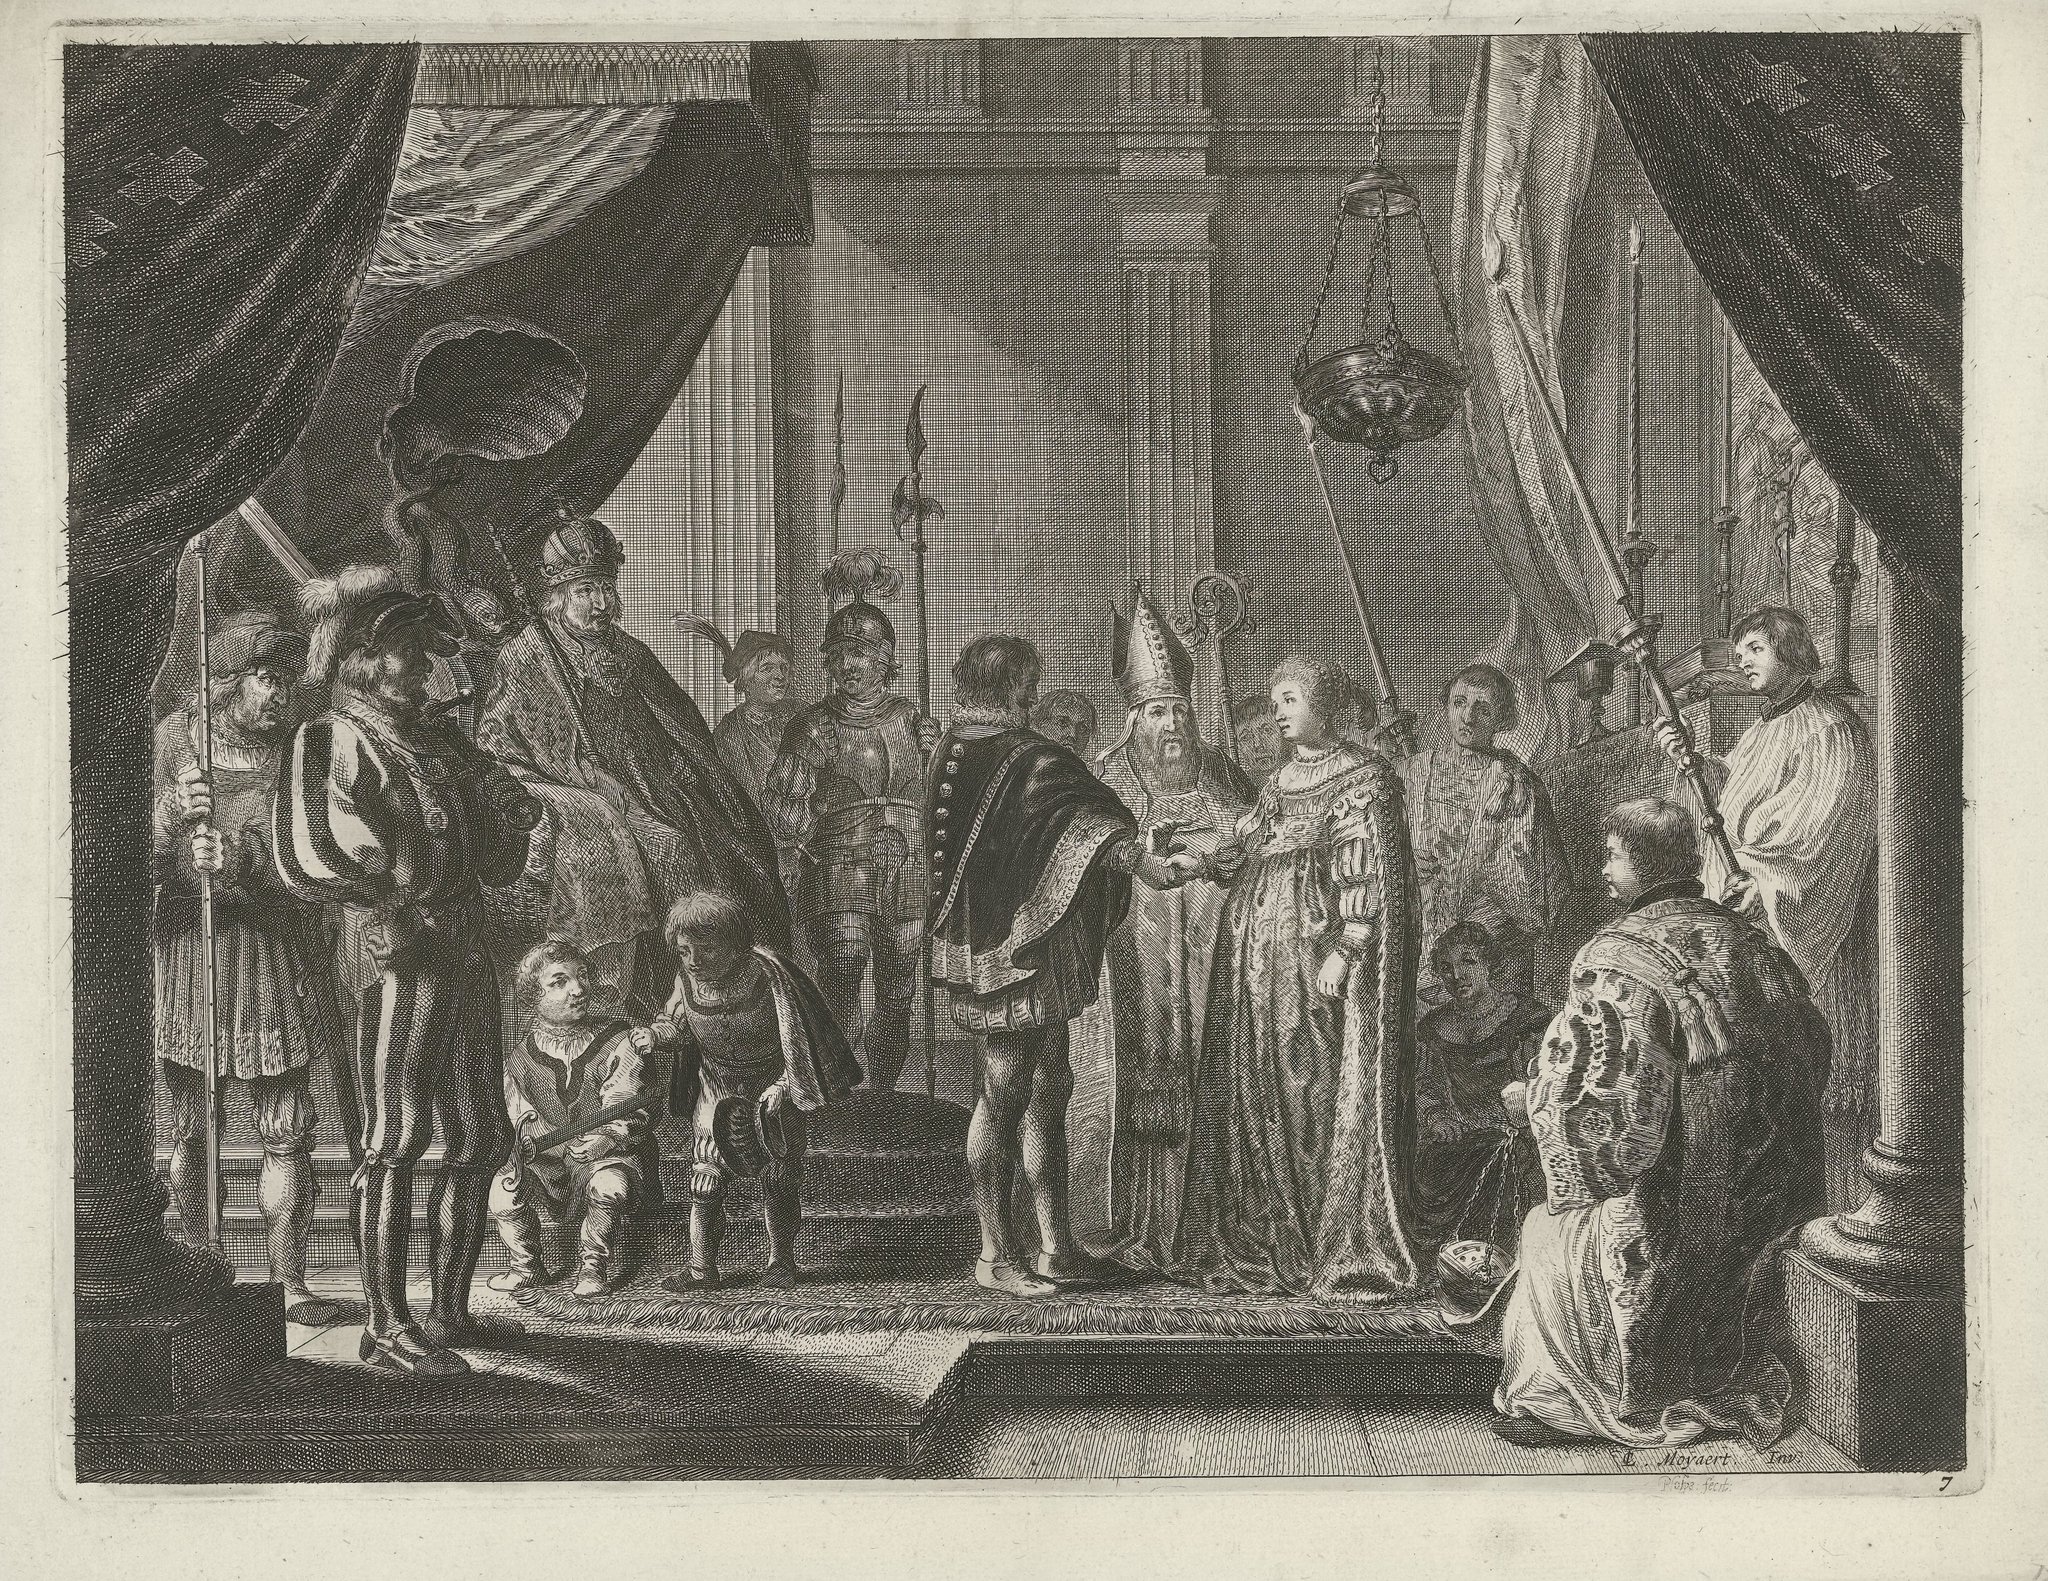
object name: print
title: Feestelijkheden bij het bezoek van Maria de' Medici aan Amsterdam in 1638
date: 1638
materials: paper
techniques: engraving, etching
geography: amsterdam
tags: prague, francesco i de' medici, cologne, print maker, maria de' medici, vienna, ferdinand i van habsburg (duits keizer), 'tableau vivant', triumphal entry and public reception, pageant, 'entrée solennelle', 'joyeuse entrée', blessing the married couple, (civil) marriage ceremonies, amsterdam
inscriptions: collector's mark: Lugt 240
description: Prent ook gebruikt in:* Baerle, Caspar van. Medicea hospes, sive descriptio publicae gratulationis, qua Serenissimam, Augustissimamque Reginam, Mariam de Medicis (…). Amsterdam: Johannes en Cornelis Willemsz. Blaeu, 1638. En in: Baerle, Caspar van. Marie de Medicis, entrant dans Amsterdam : ou, histoire de la reception faicte à la Reyne Mere du Roy tres-Chrestien (…). Amsterdam: Johannes en Cornelis Willemsz. Blaeu, 1638. En in: Baerle, Caspar van en Joost van den Vondel. Blyde inkomst der allerdoorluchtighste koninginne, Maria de Medicis t' Amsterdam. Vertaelt uit het Latijn (…). Amsterdam: Johannes en Cornelis Willemsz. Blaeu, 1639. * Doorgaans zijn de prenten in de bovengenoemde publicaties rechtsonder genummerd (van de huidige prent is dat de derde bekende staat). Maar er zijn ook exemplaren waarin eerdere, ongenummerde, staten van de prenten (van de huidige prent de eerste en tweede bekende staat) zijn ingebonden.